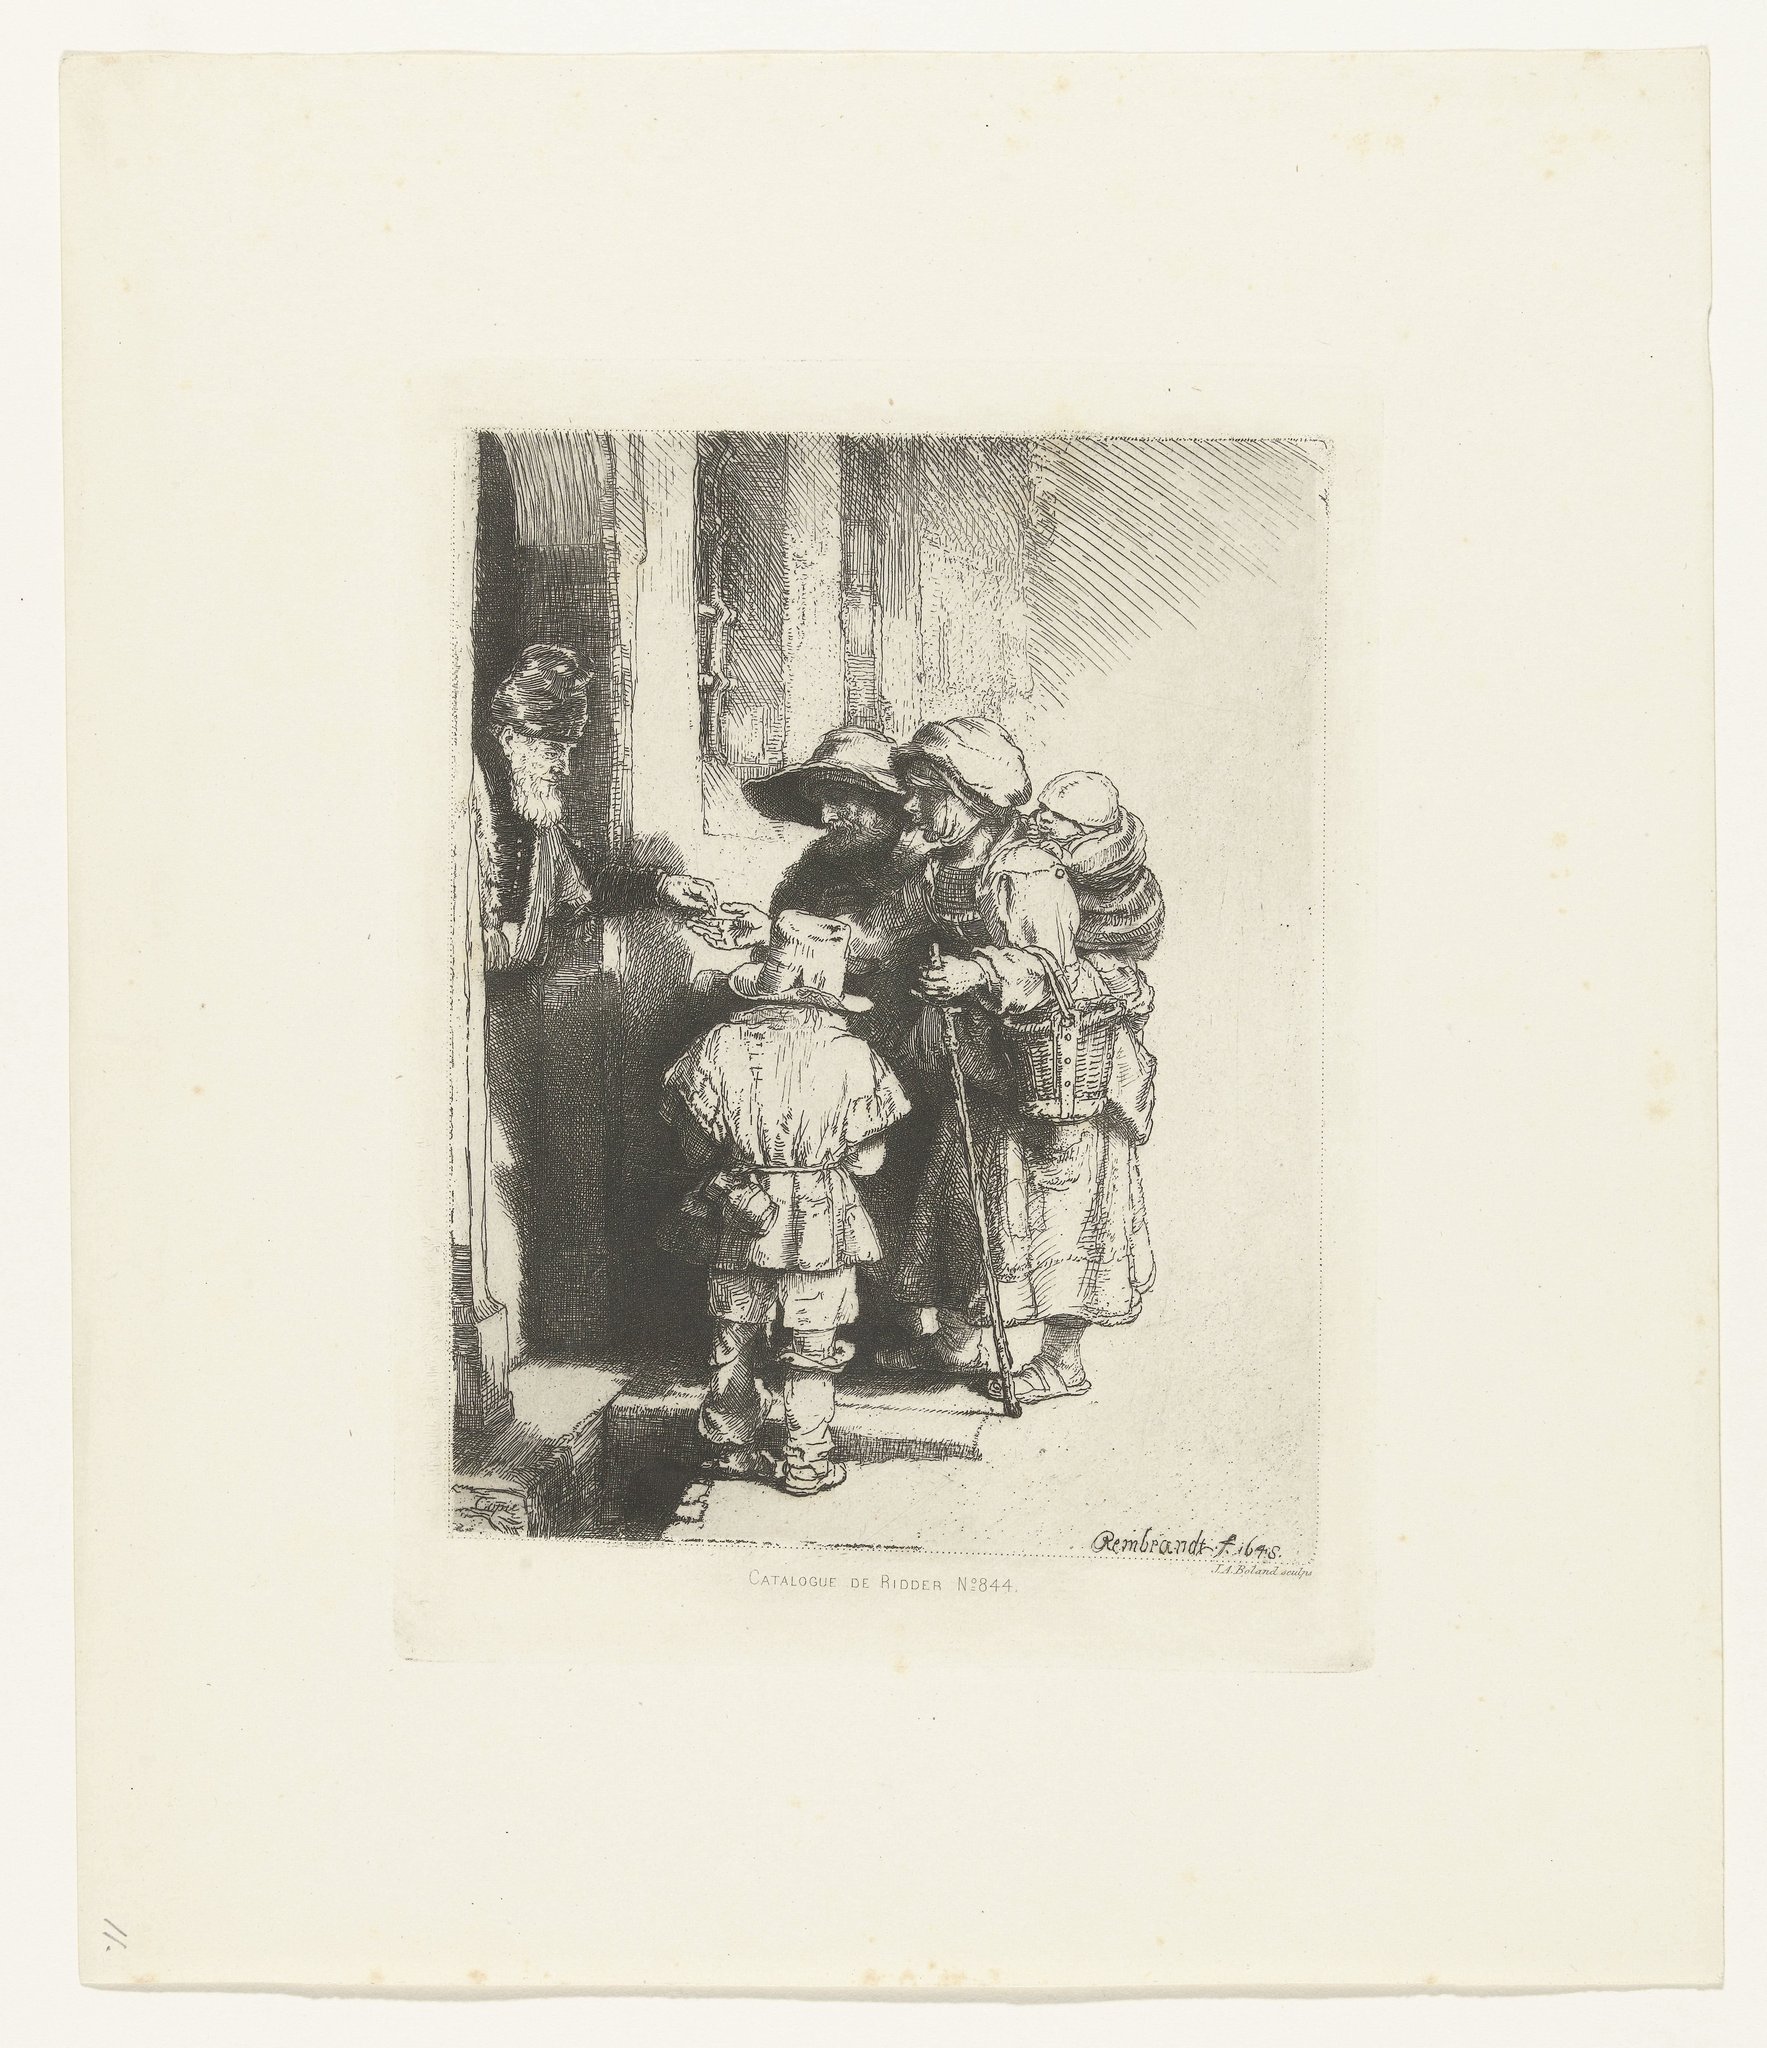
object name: print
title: Bedelaars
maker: johannes arnoldus boland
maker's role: print maker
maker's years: 1838-1922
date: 1874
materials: paper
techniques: etching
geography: amsterdam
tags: beggar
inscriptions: collector's mark: Lugt 2228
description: Illustratie voor de catalogus van de collectie C.C.J. de Ridder (Utrecht), verschenen in 1874.